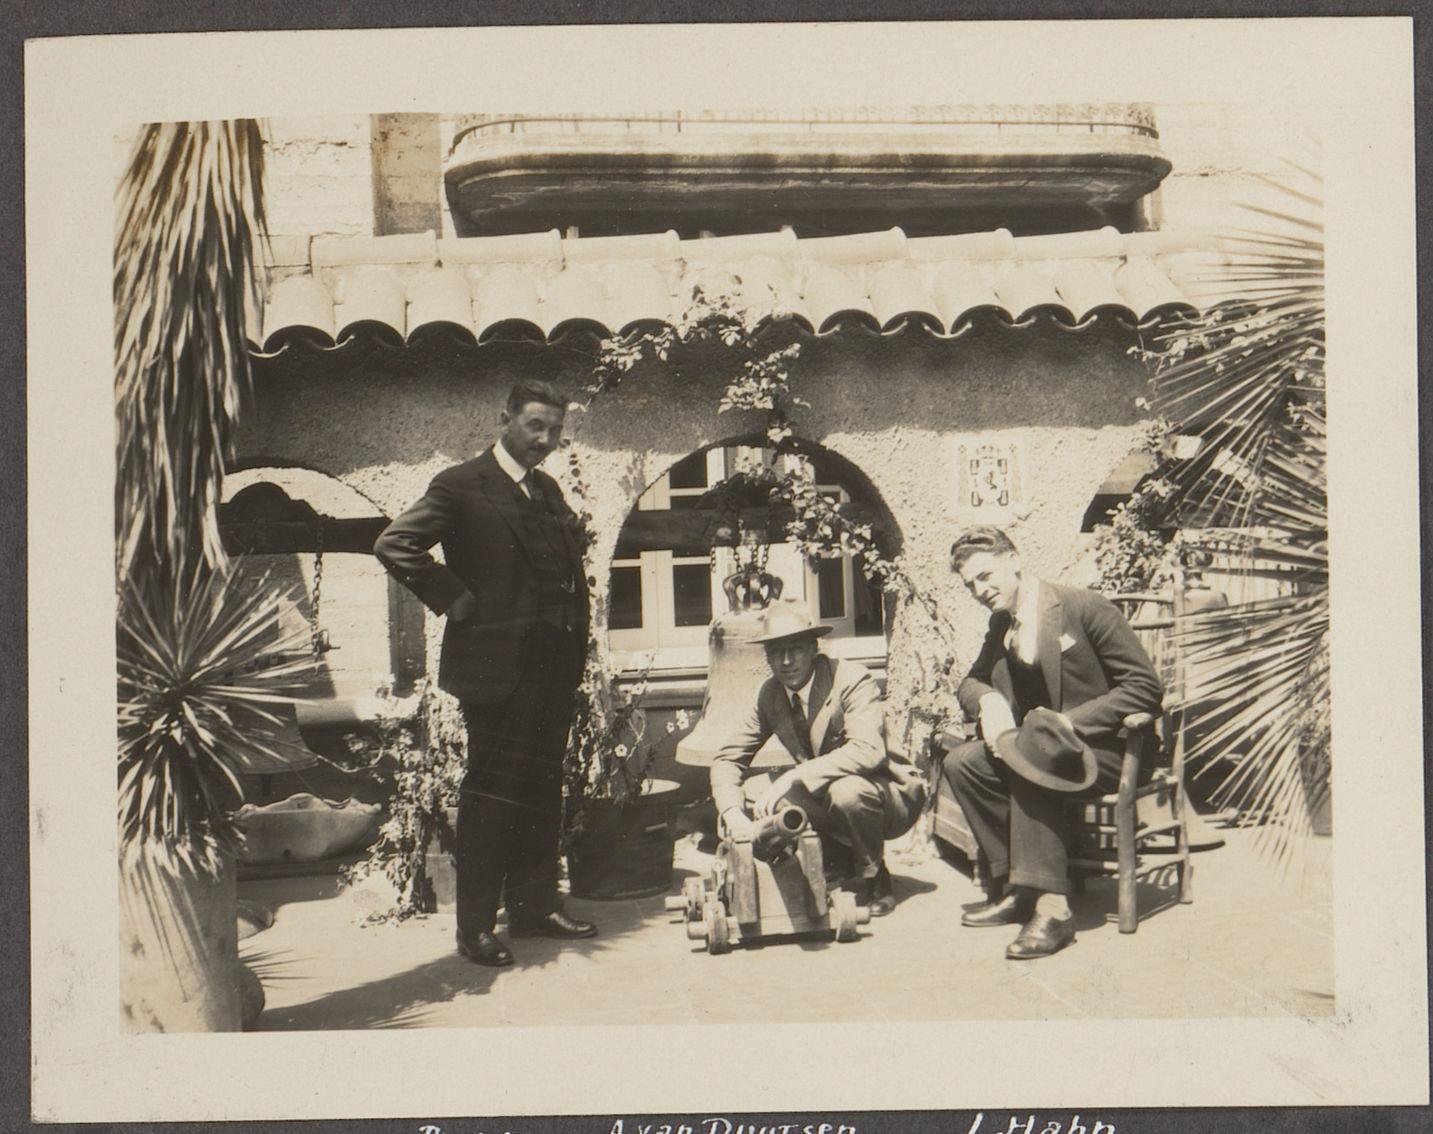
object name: album leaf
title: Portret van Rupp, A. van Duursen en L. Hahn bij de Mission Inn te Riverside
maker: Anonymous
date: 1928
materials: photographic support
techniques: gelatin silver print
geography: riverside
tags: adult man, historical persons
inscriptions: annotation: ‘Mission Inn Riverside’